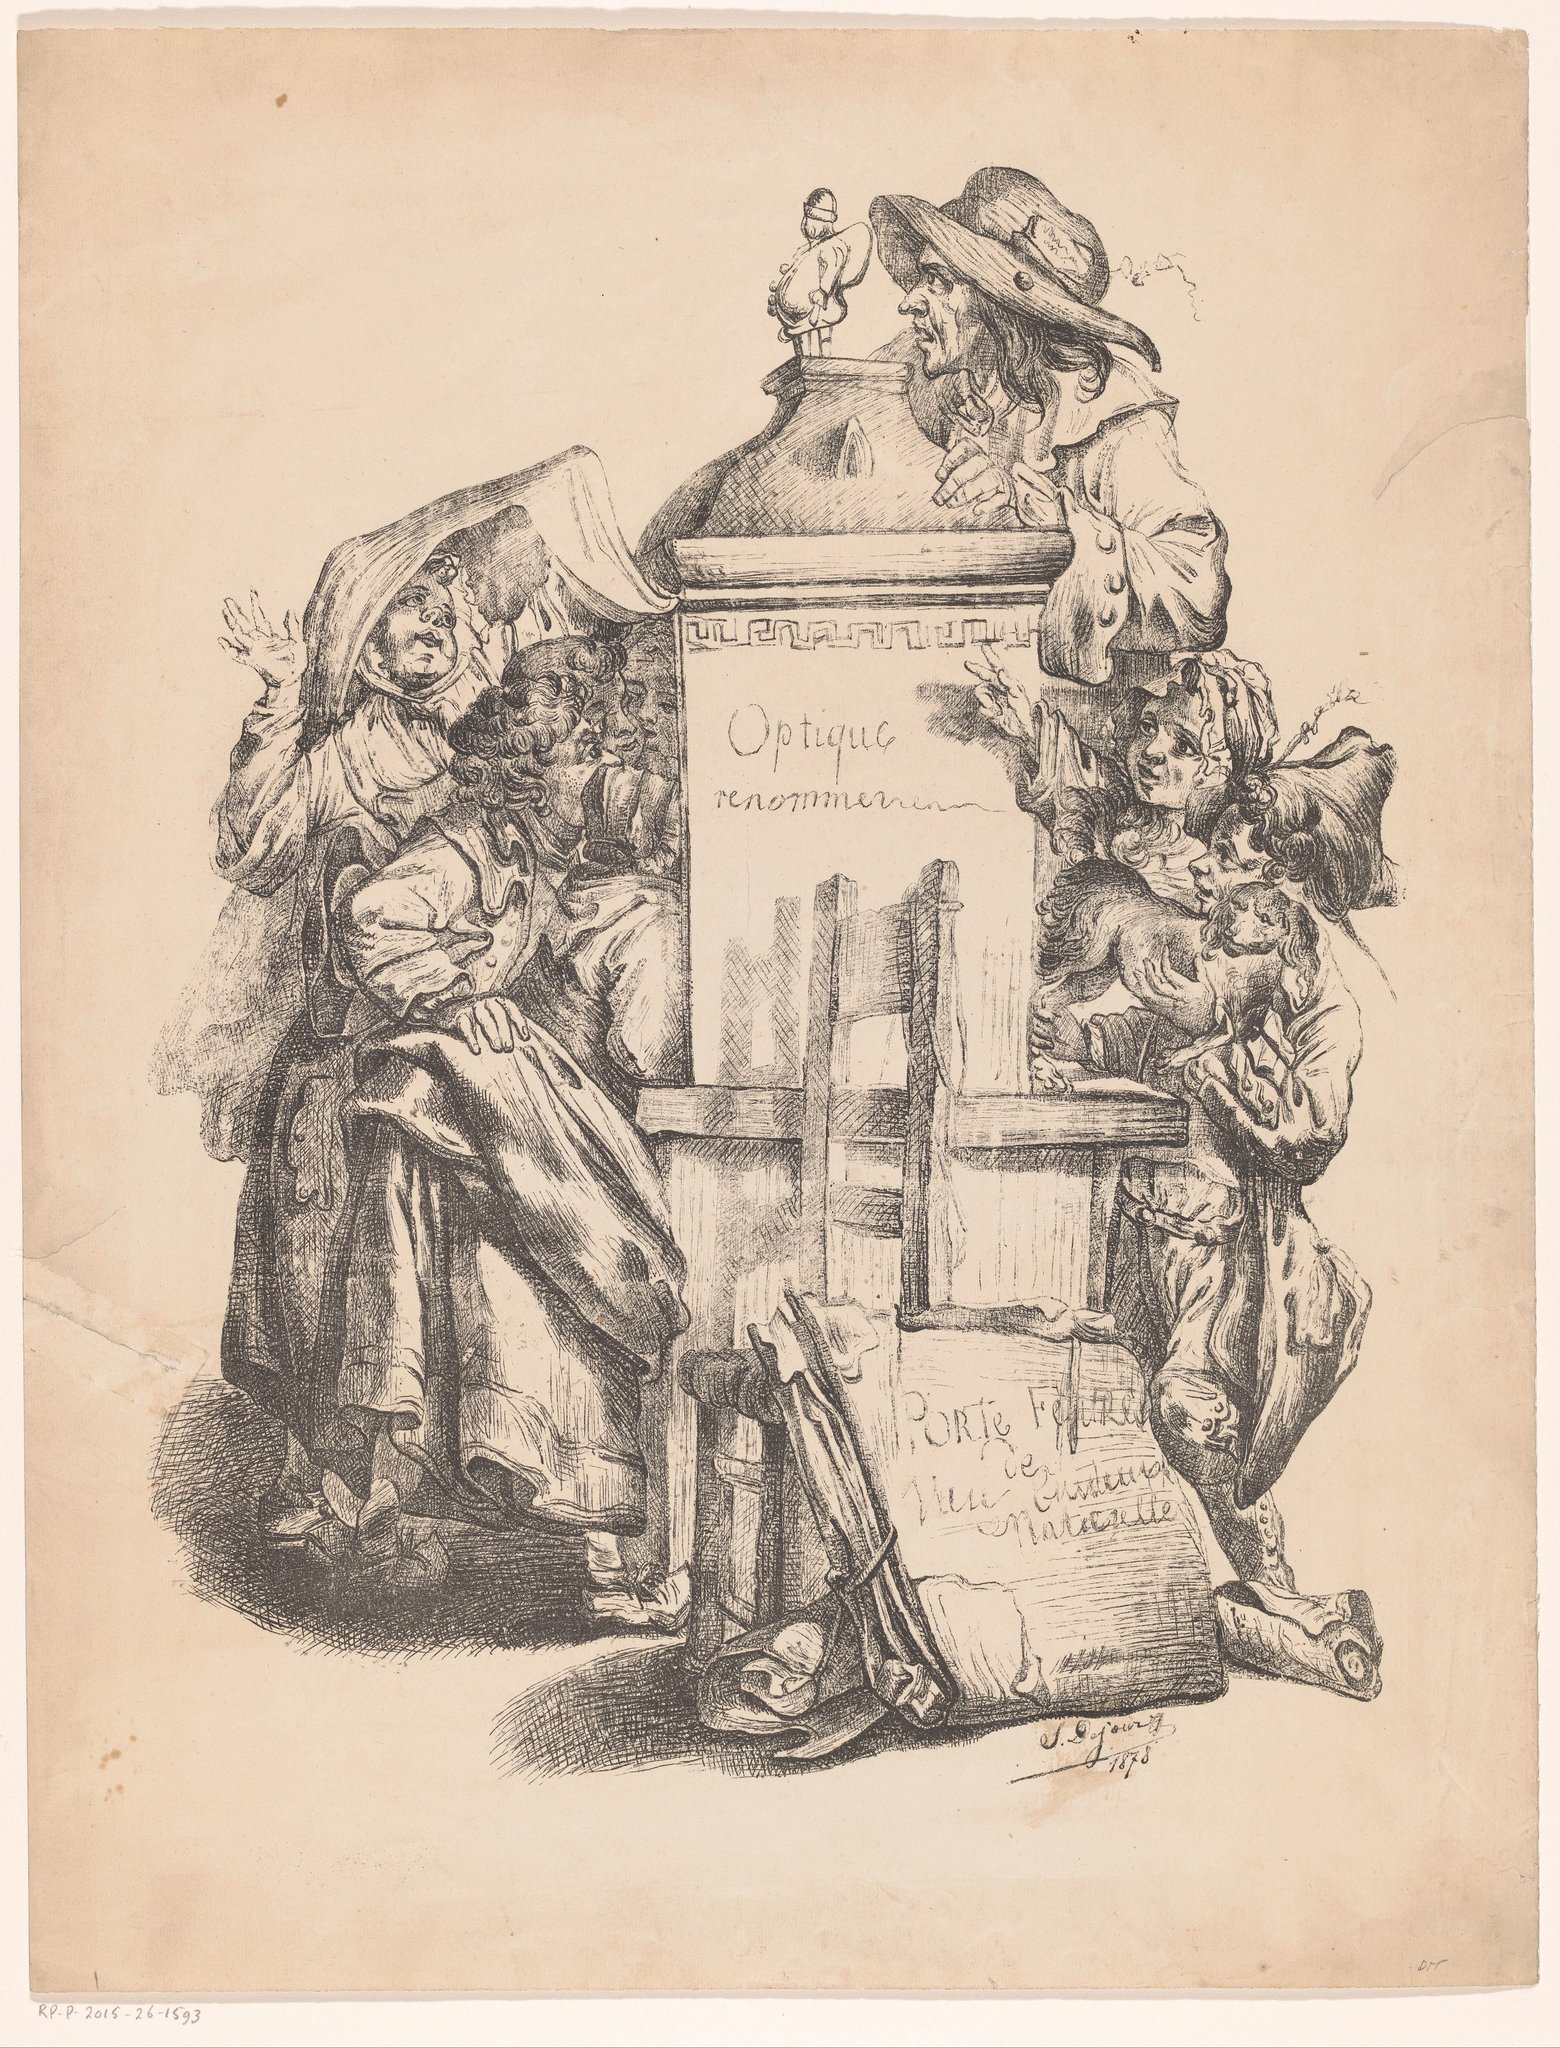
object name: print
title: Kinderen rond een kijkkast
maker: s. dejour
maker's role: print maker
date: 1878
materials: paper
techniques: lithograph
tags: peep-show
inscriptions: collector's mark: Lugt 4779, collector's mark: Lugt 2228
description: Zeven jongens en meisjes hebben zich verzameld rond een kijkkast met bovenop een man met een bochel. Achter de kast staat de eigenaar. Voor de kijkkast leunt een portfolio met prenten tegen een stoel.